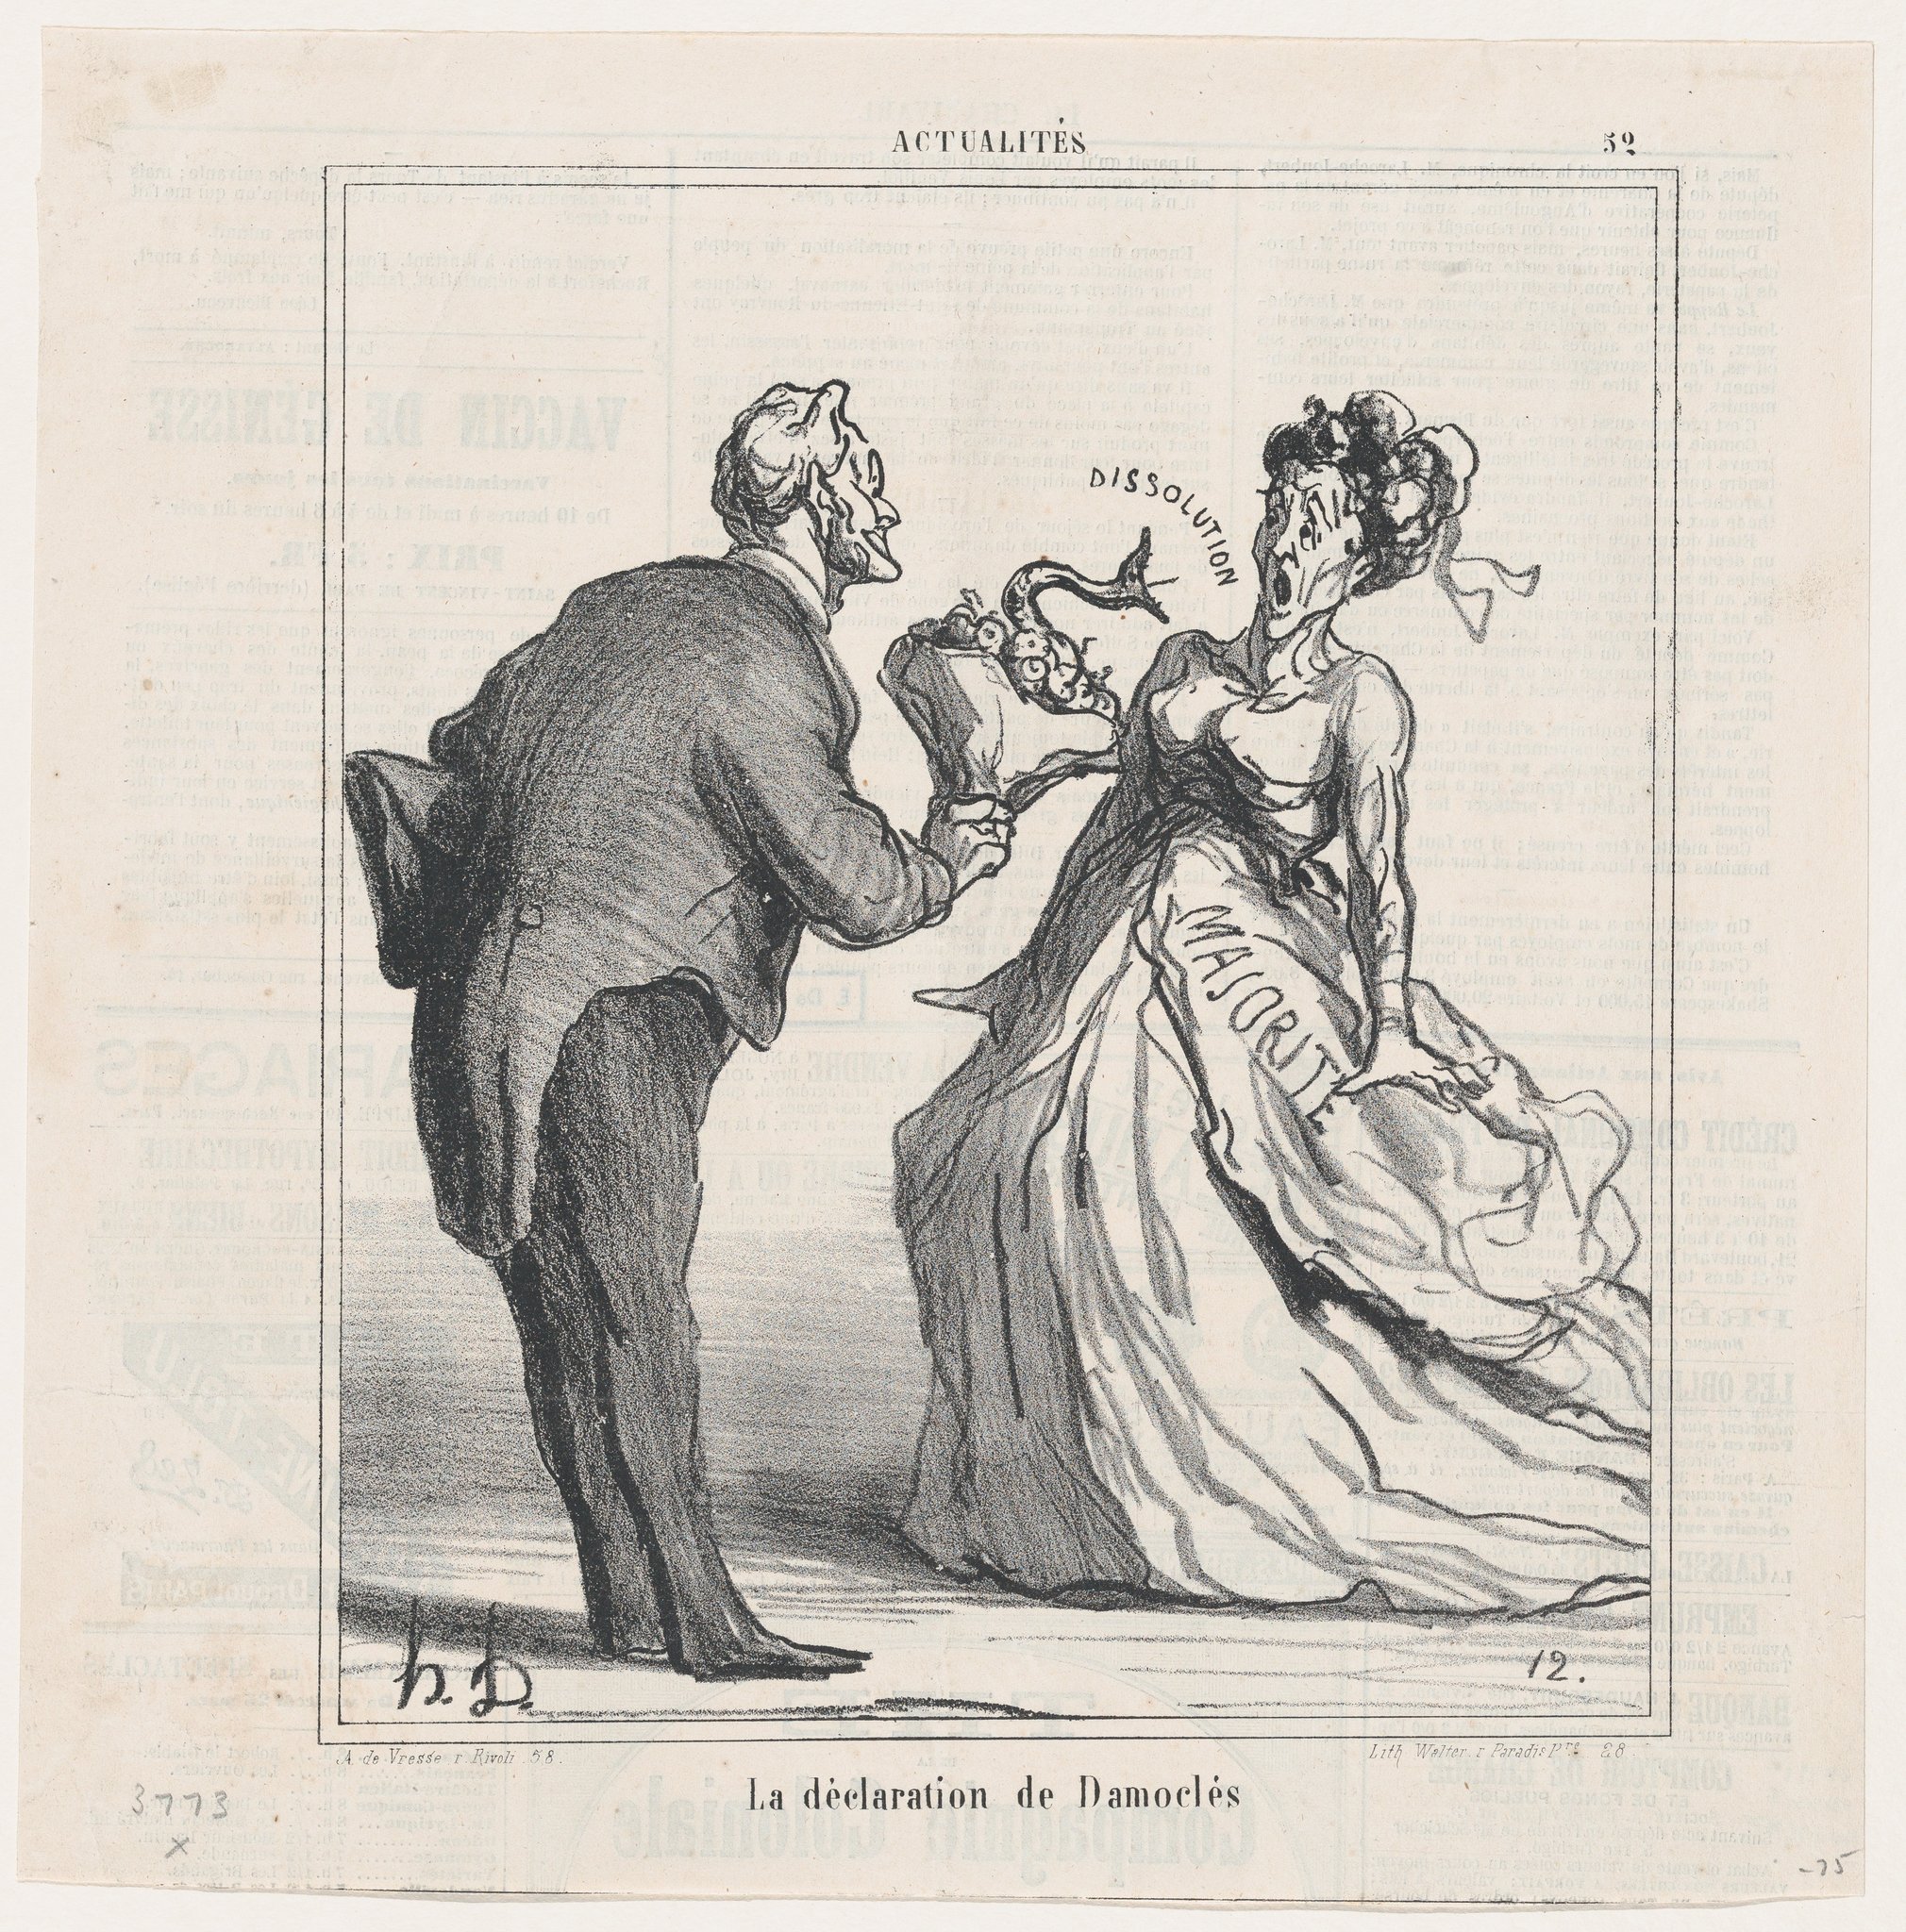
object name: print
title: The declaration of Damocles, from "News of the day"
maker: honoré daumier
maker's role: artist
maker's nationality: french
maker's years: 1808-1879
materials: paper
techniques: lithograph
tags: satire,men,women